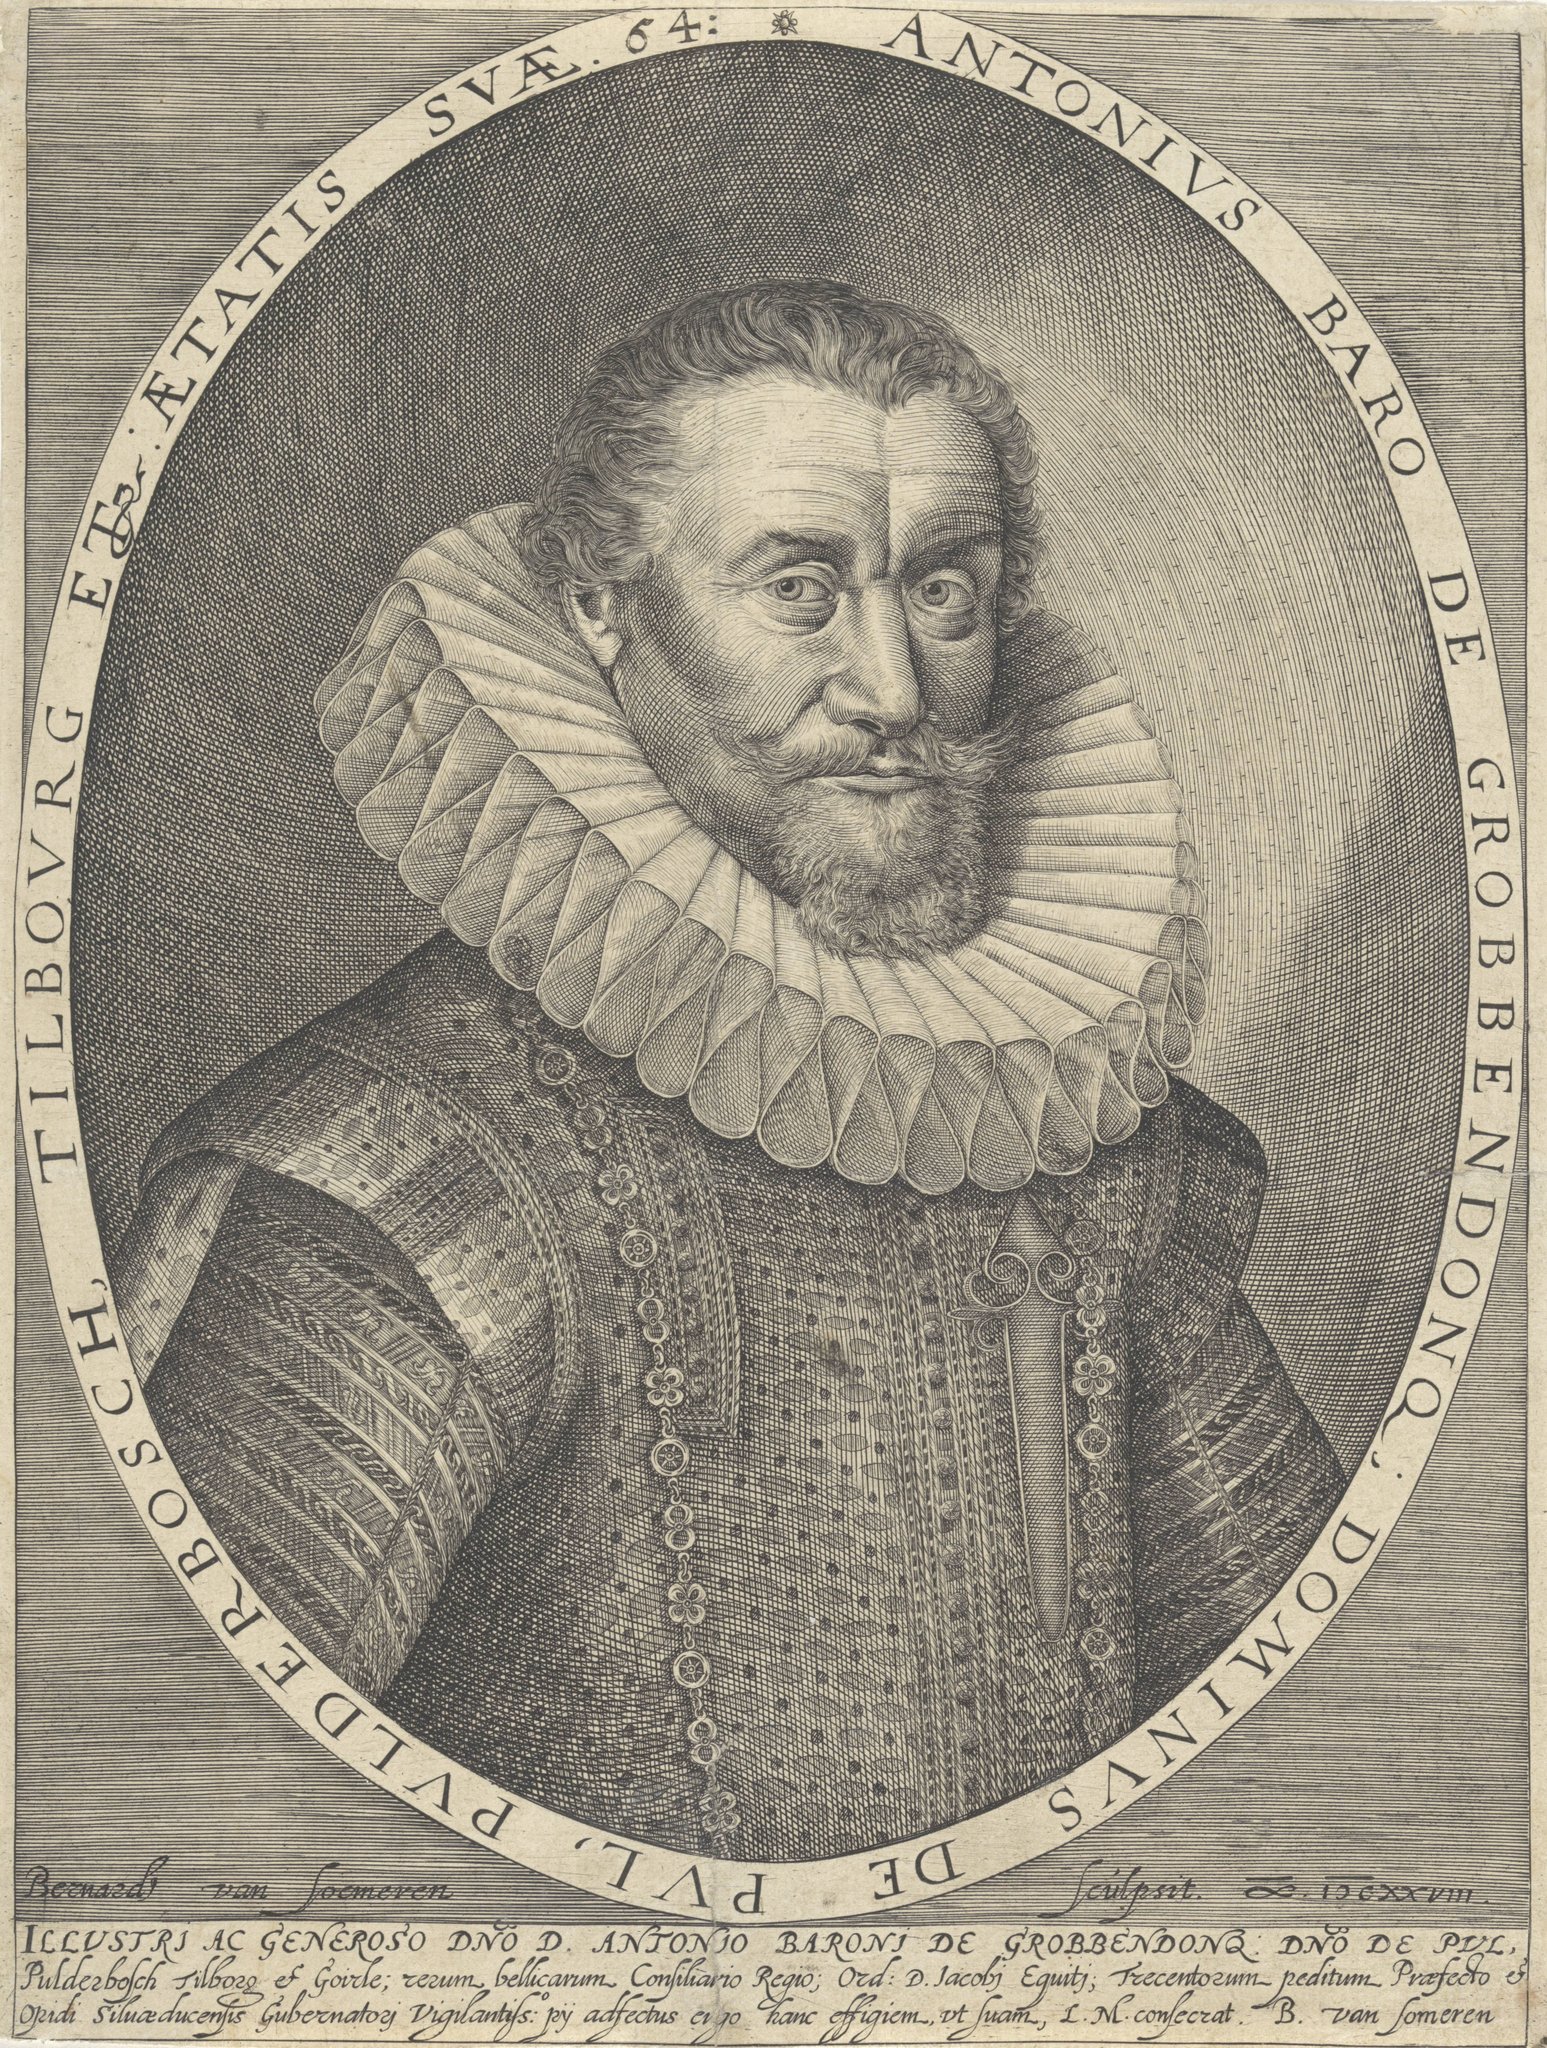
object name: print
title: Portret van Anthonie Schets, Baron van Grobbendonck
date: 1628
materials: paper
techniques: engraving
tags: antwerp, brussels, anthonie schets baron van grobbendonck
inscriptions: collector's mark: Lugt 2228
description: Portret van Anthonie Schets, Baron van Grobbendonck, op 64-jarige leeftijd. Hij was de militaire gouverneur van Den Bosch onder Spaans gezag van 1598-1629. Op de ovale randlijst zijn naam, titel en leeftijd. Onderaan in het Latijn zijn titels en functies.